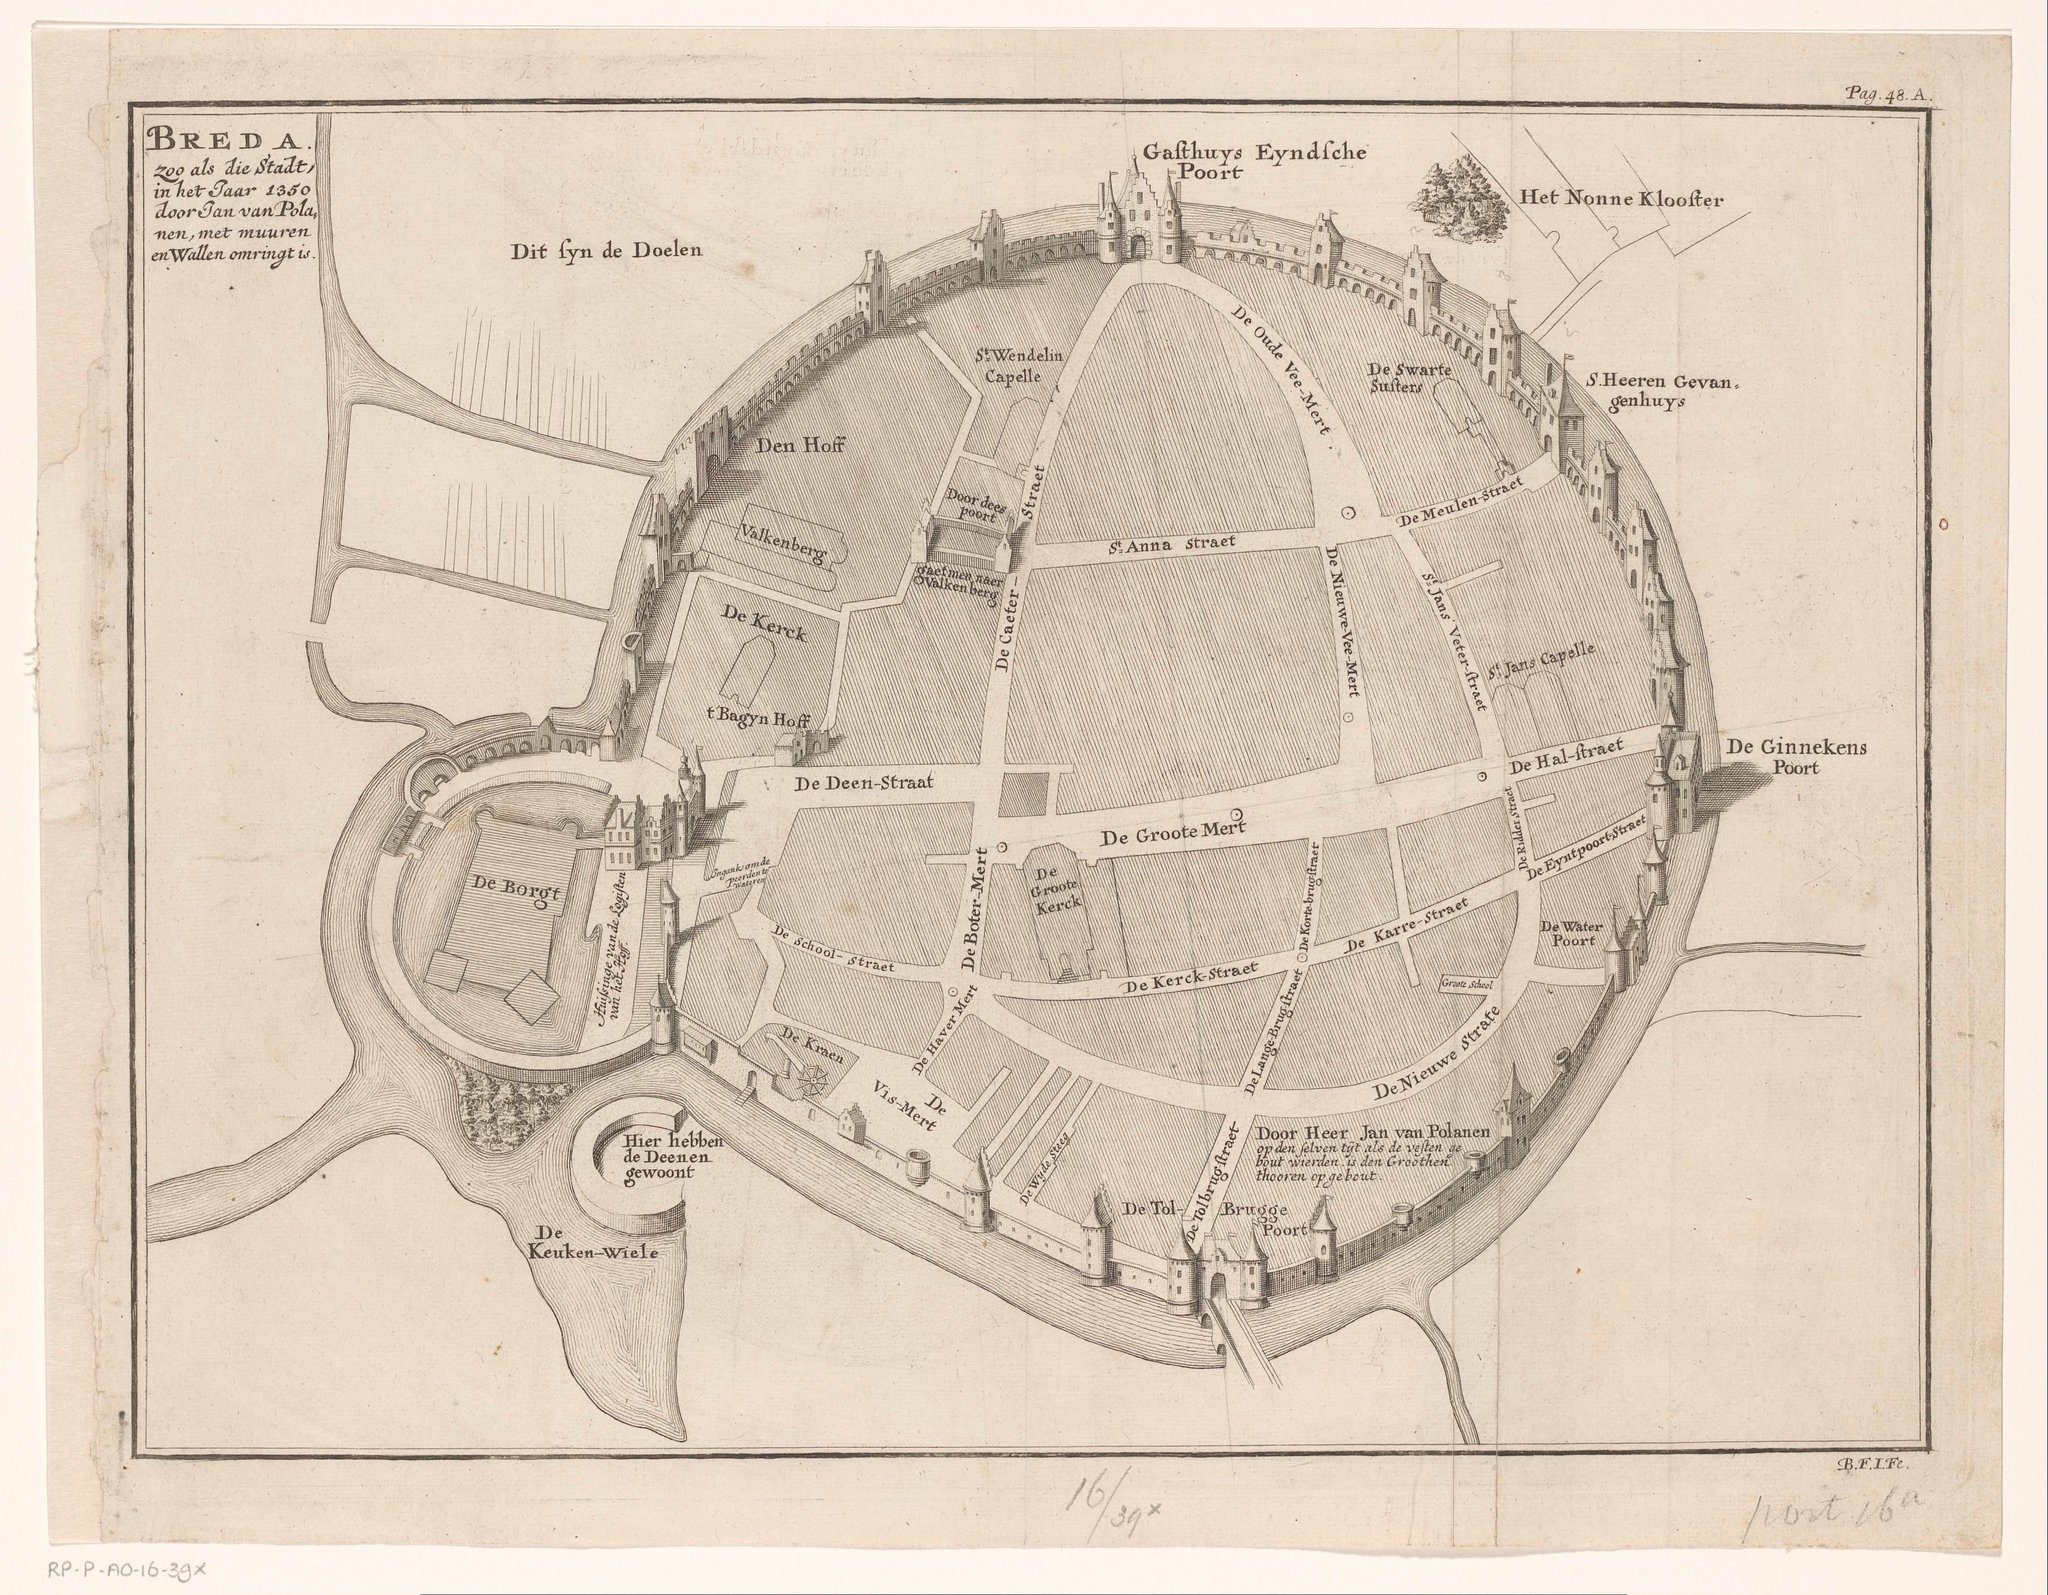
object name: area plan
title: Breda zoo als die stadt, in het jaar 1350 door Jan van Polanen, met muuren en wallen omringt is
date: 1744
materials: paper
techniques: engraving, etching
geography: the hague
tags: fortified city, maps of cities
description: Prent ook gebruikt in: Goor, Thomas Ernst van. Beschryving der stadt en lande van Breda: behelzende de oudheid van het graaffschap Stryen (…). Den Haag: Jacobus van den Kieboom, 1744, p. 48.